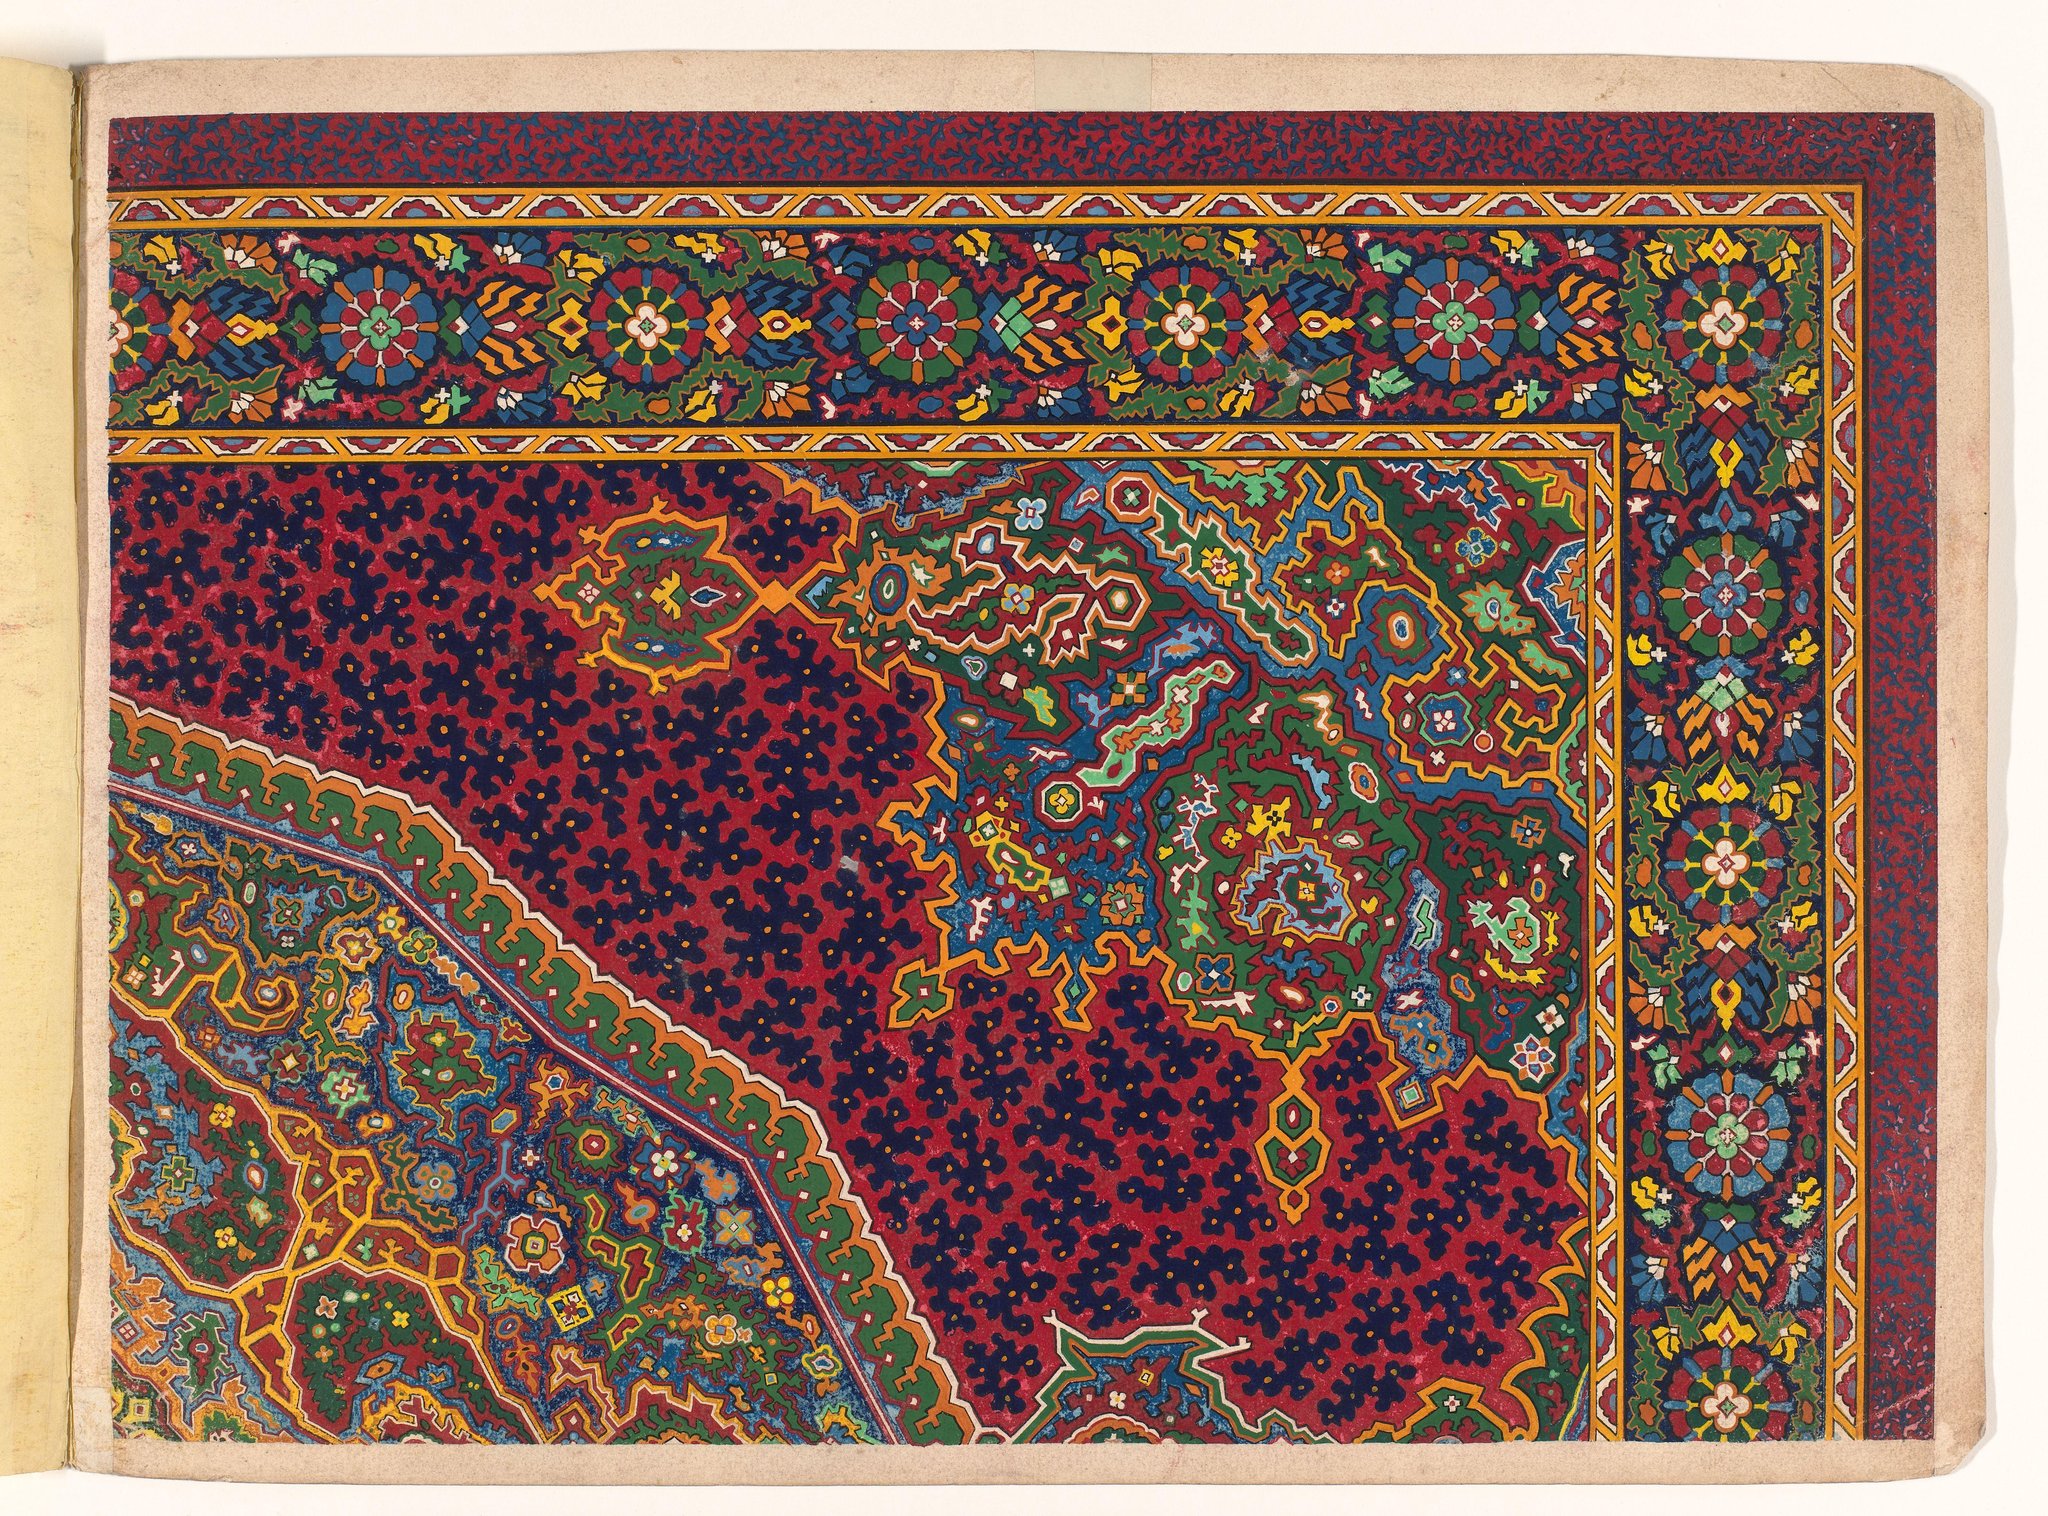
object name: drawing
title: Ontwerp voor een tapijt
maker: Anonymous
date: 1854-1864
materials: gouache, paper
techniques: brush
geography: amsterdam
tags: ornaments ~ art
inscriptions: inscription: ‘O’, number: ‘N 42.’, retailer's mark: ‘JHS.’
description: Een tapijt vervaardigd naar voorbeeld van deze modeltekening is gebruikt bij de inrichting van zaal van Huis van Brienen aan de Herengracht in Amsterdam. De presentatietekeningen BK-1971-77-1 t/m 86 zijn kopieën van de originele ontwerptekeningen. Ze werden gemaakt voor vertegenwoordigers van bijvoorbeeld magazijnen, die ze aan hun klanten konden tonen. De meeste tekeningen tonen een kwart van het dessin inclusief rand, middenpartij (de zogenaamde grond of fond) en centraal medaillon. Door het gebruik van spiegels kan de illusie van het gehele tapijt worden opgeroepen. Een deel van de tekeningen heeft een alfabetische opeenvolgende letter als kenmerk, de andere groep een cijfer.Waarschijnlijk is de reeks dessins met een letter eerder samengesteld dan de genummerde tekeningen.